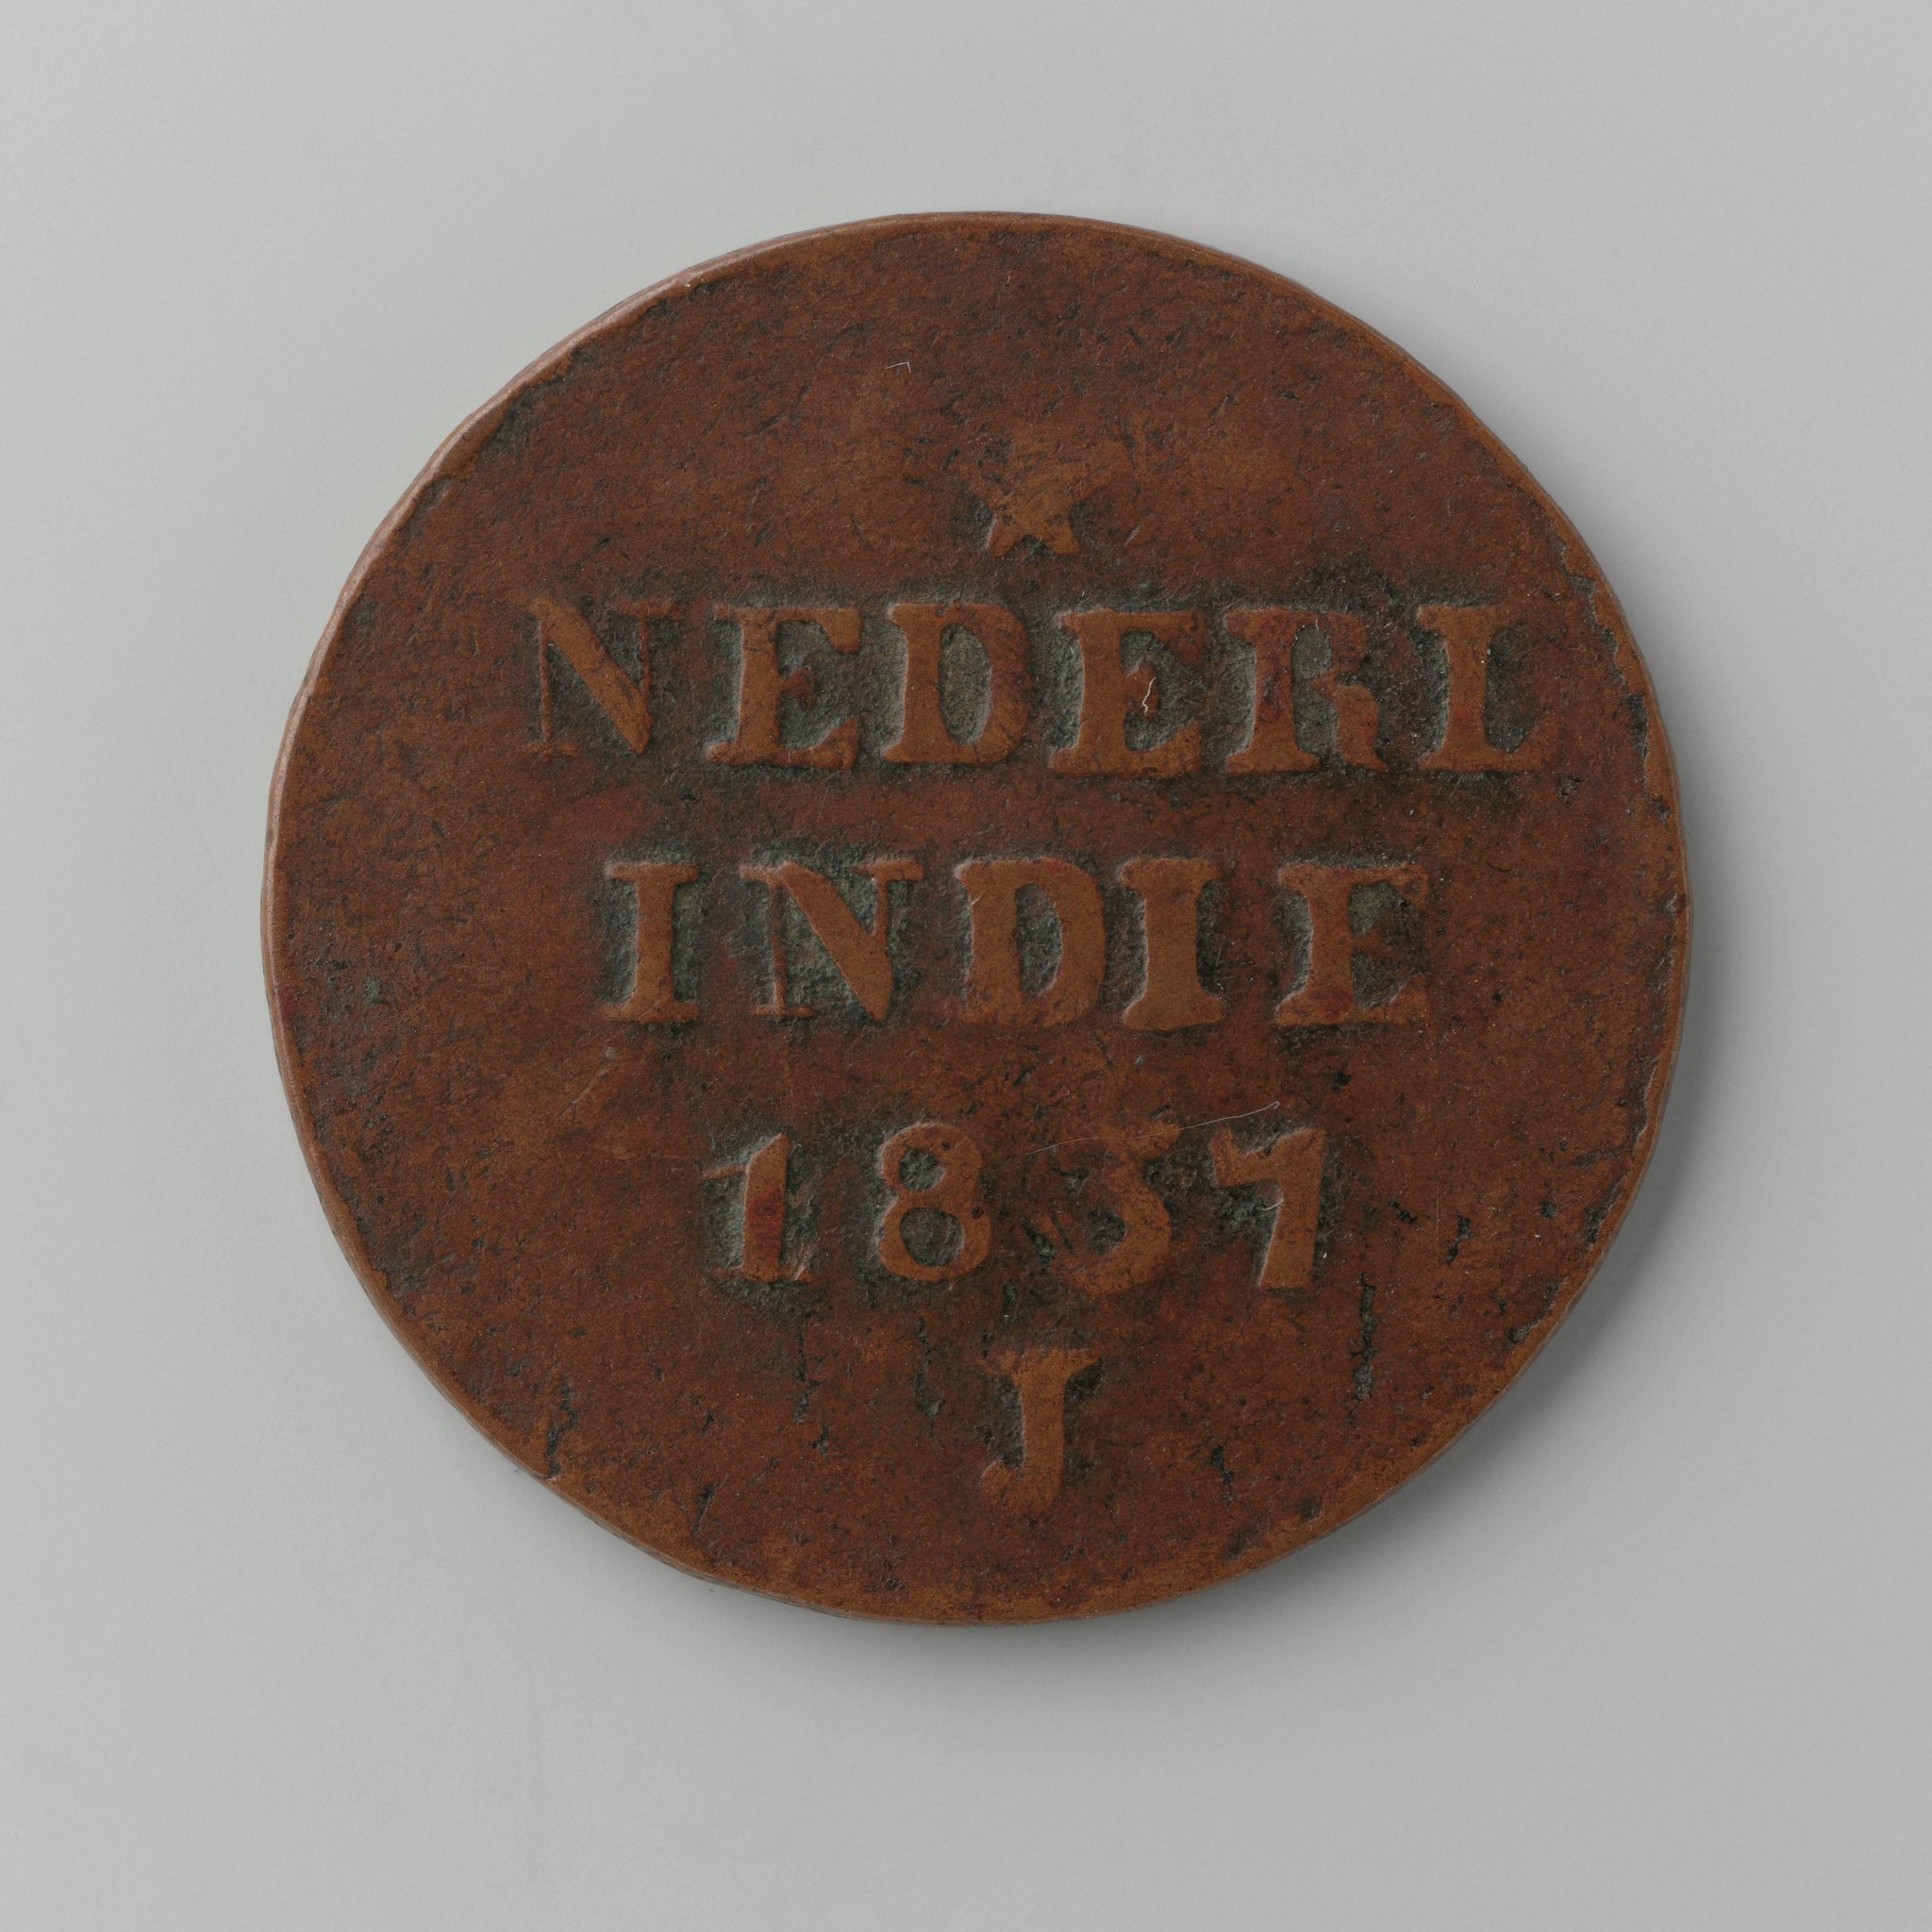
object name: coin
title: Nederlands Indië, 2 cent,1837 J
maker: william i of the netherlands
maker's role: koning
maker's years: 1772-1843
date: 1837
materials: copper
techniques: striking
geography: surabaya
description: Koperen munt. Voorzijde: tussen waarde-aanduiding 2 CT. gekroond rijkswapenschild. Keerzijde: tweeregelig opschrift, waarboven muntteken en waaronder jaartal. Daaronder letter J [=muntmeester Jeekel]. Gladde rand.